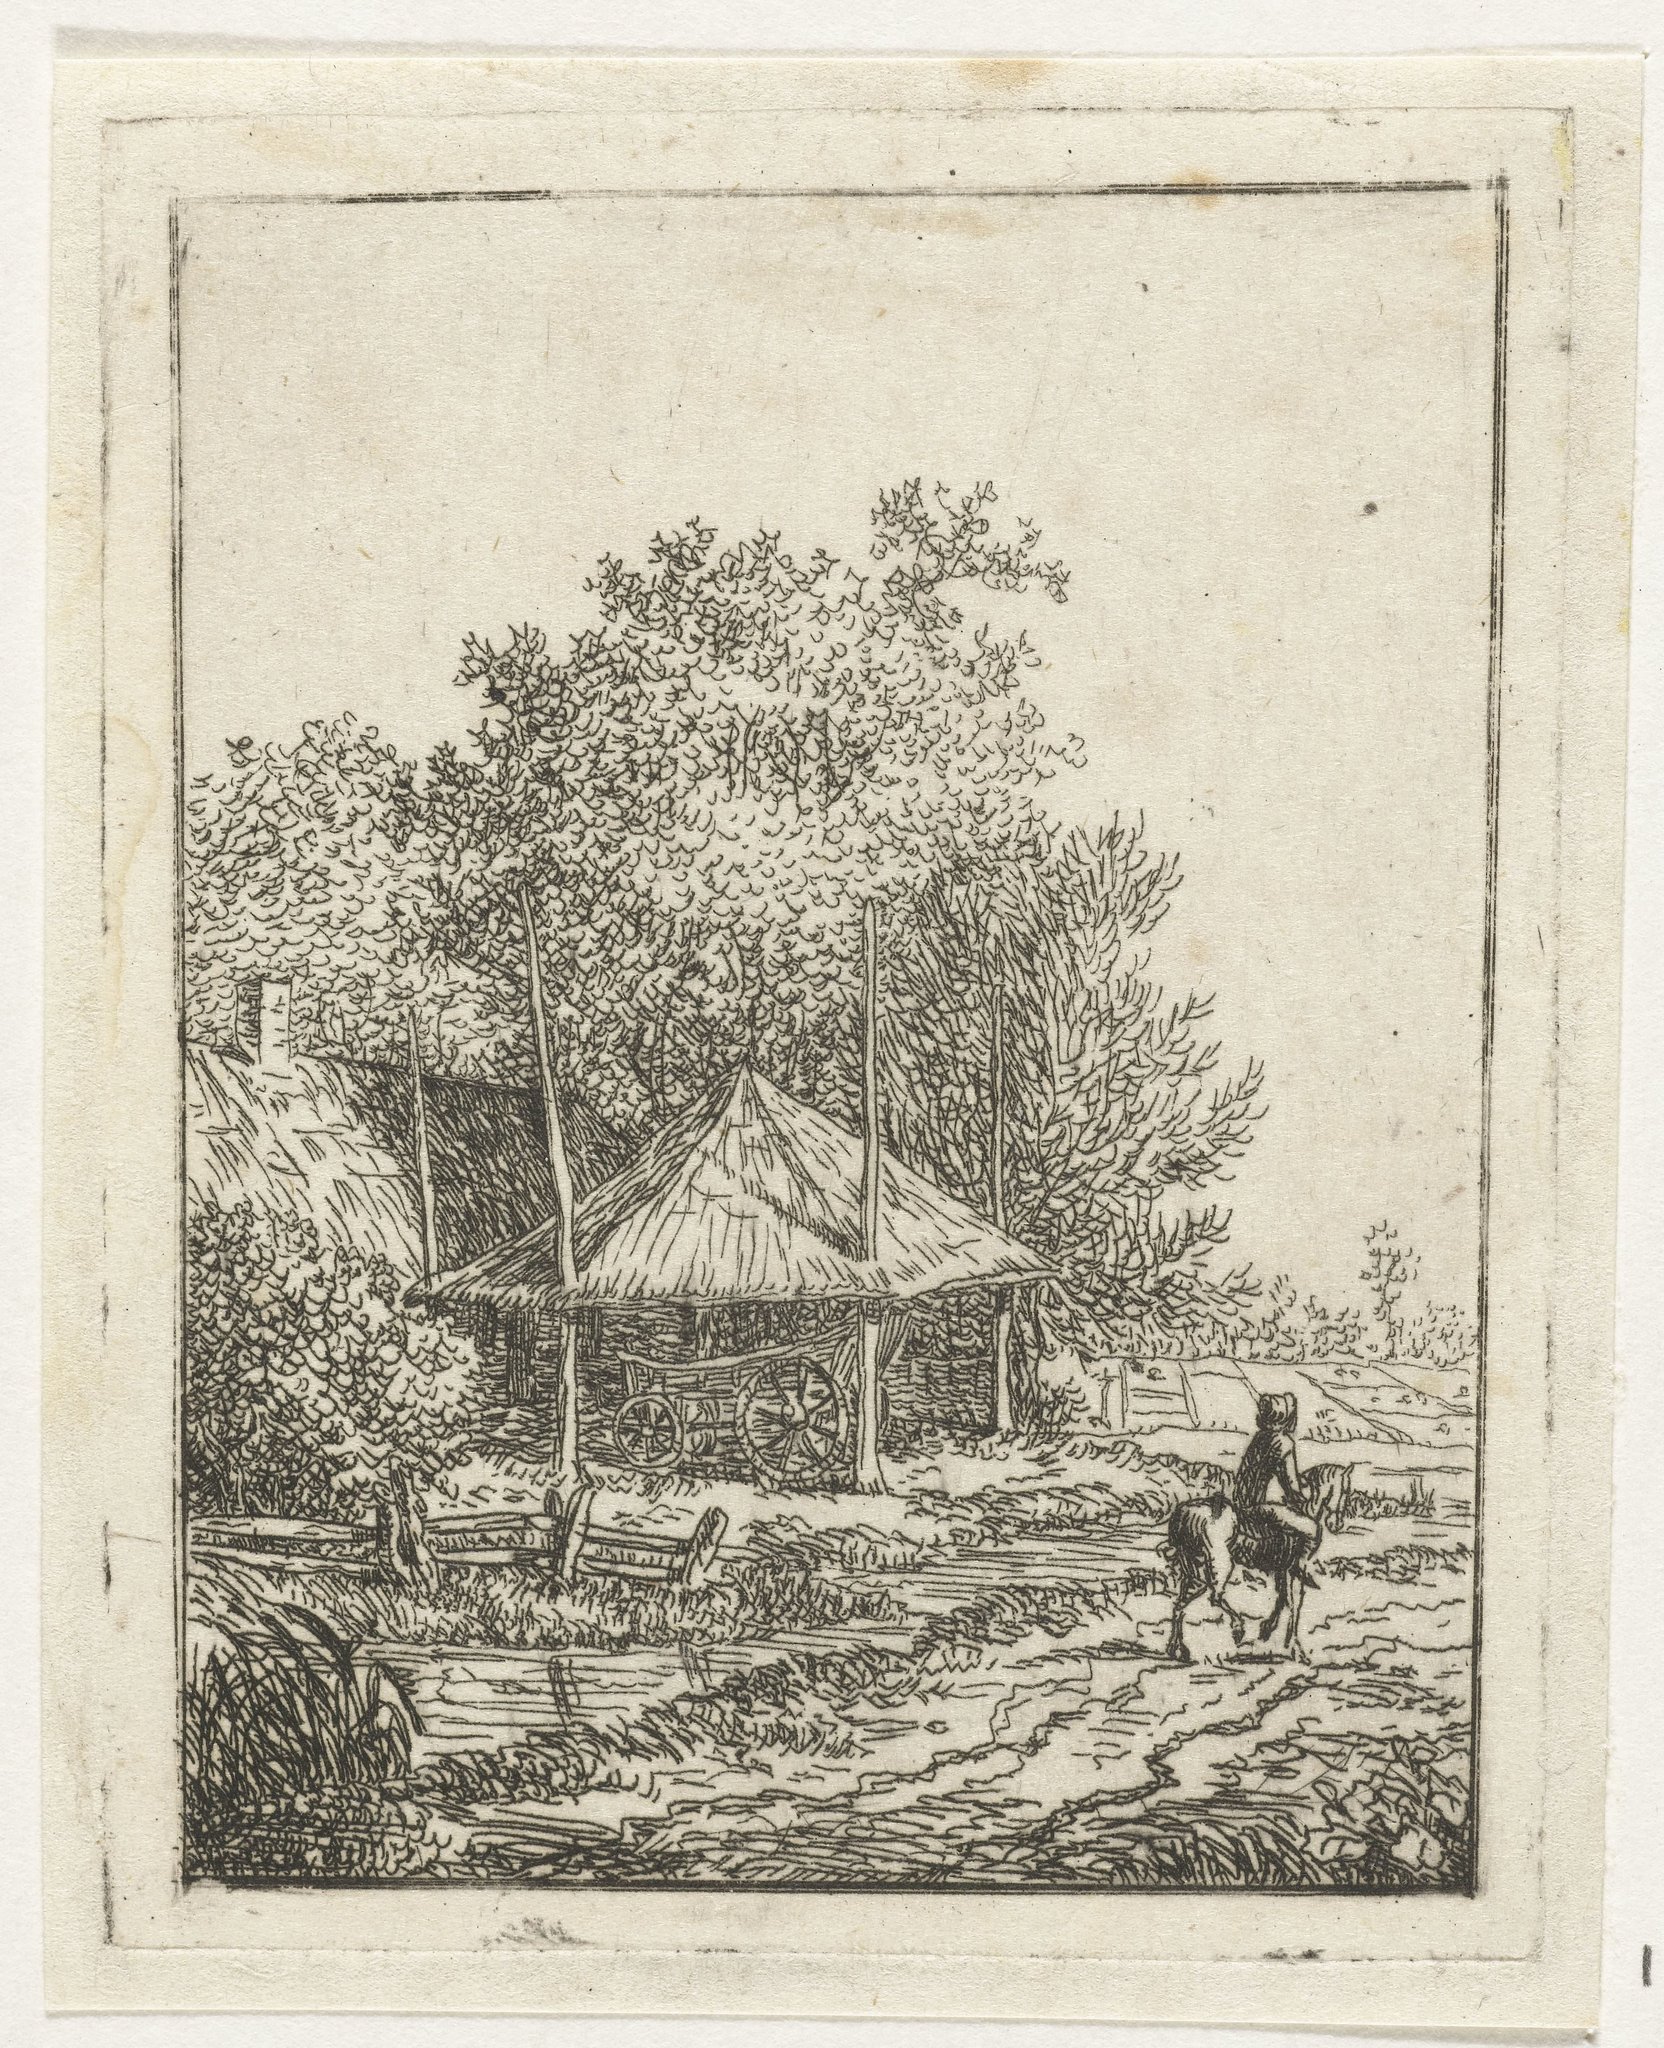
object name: print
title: Ruiter bij boerderij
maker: anthonie van den bos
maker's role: draughtsman, print maker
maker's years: 1763-1838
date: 1778-1838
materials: paper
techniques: etching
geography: netherlands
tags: farm or solitary house in landscape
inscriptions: collector's mark: Lugt 2228